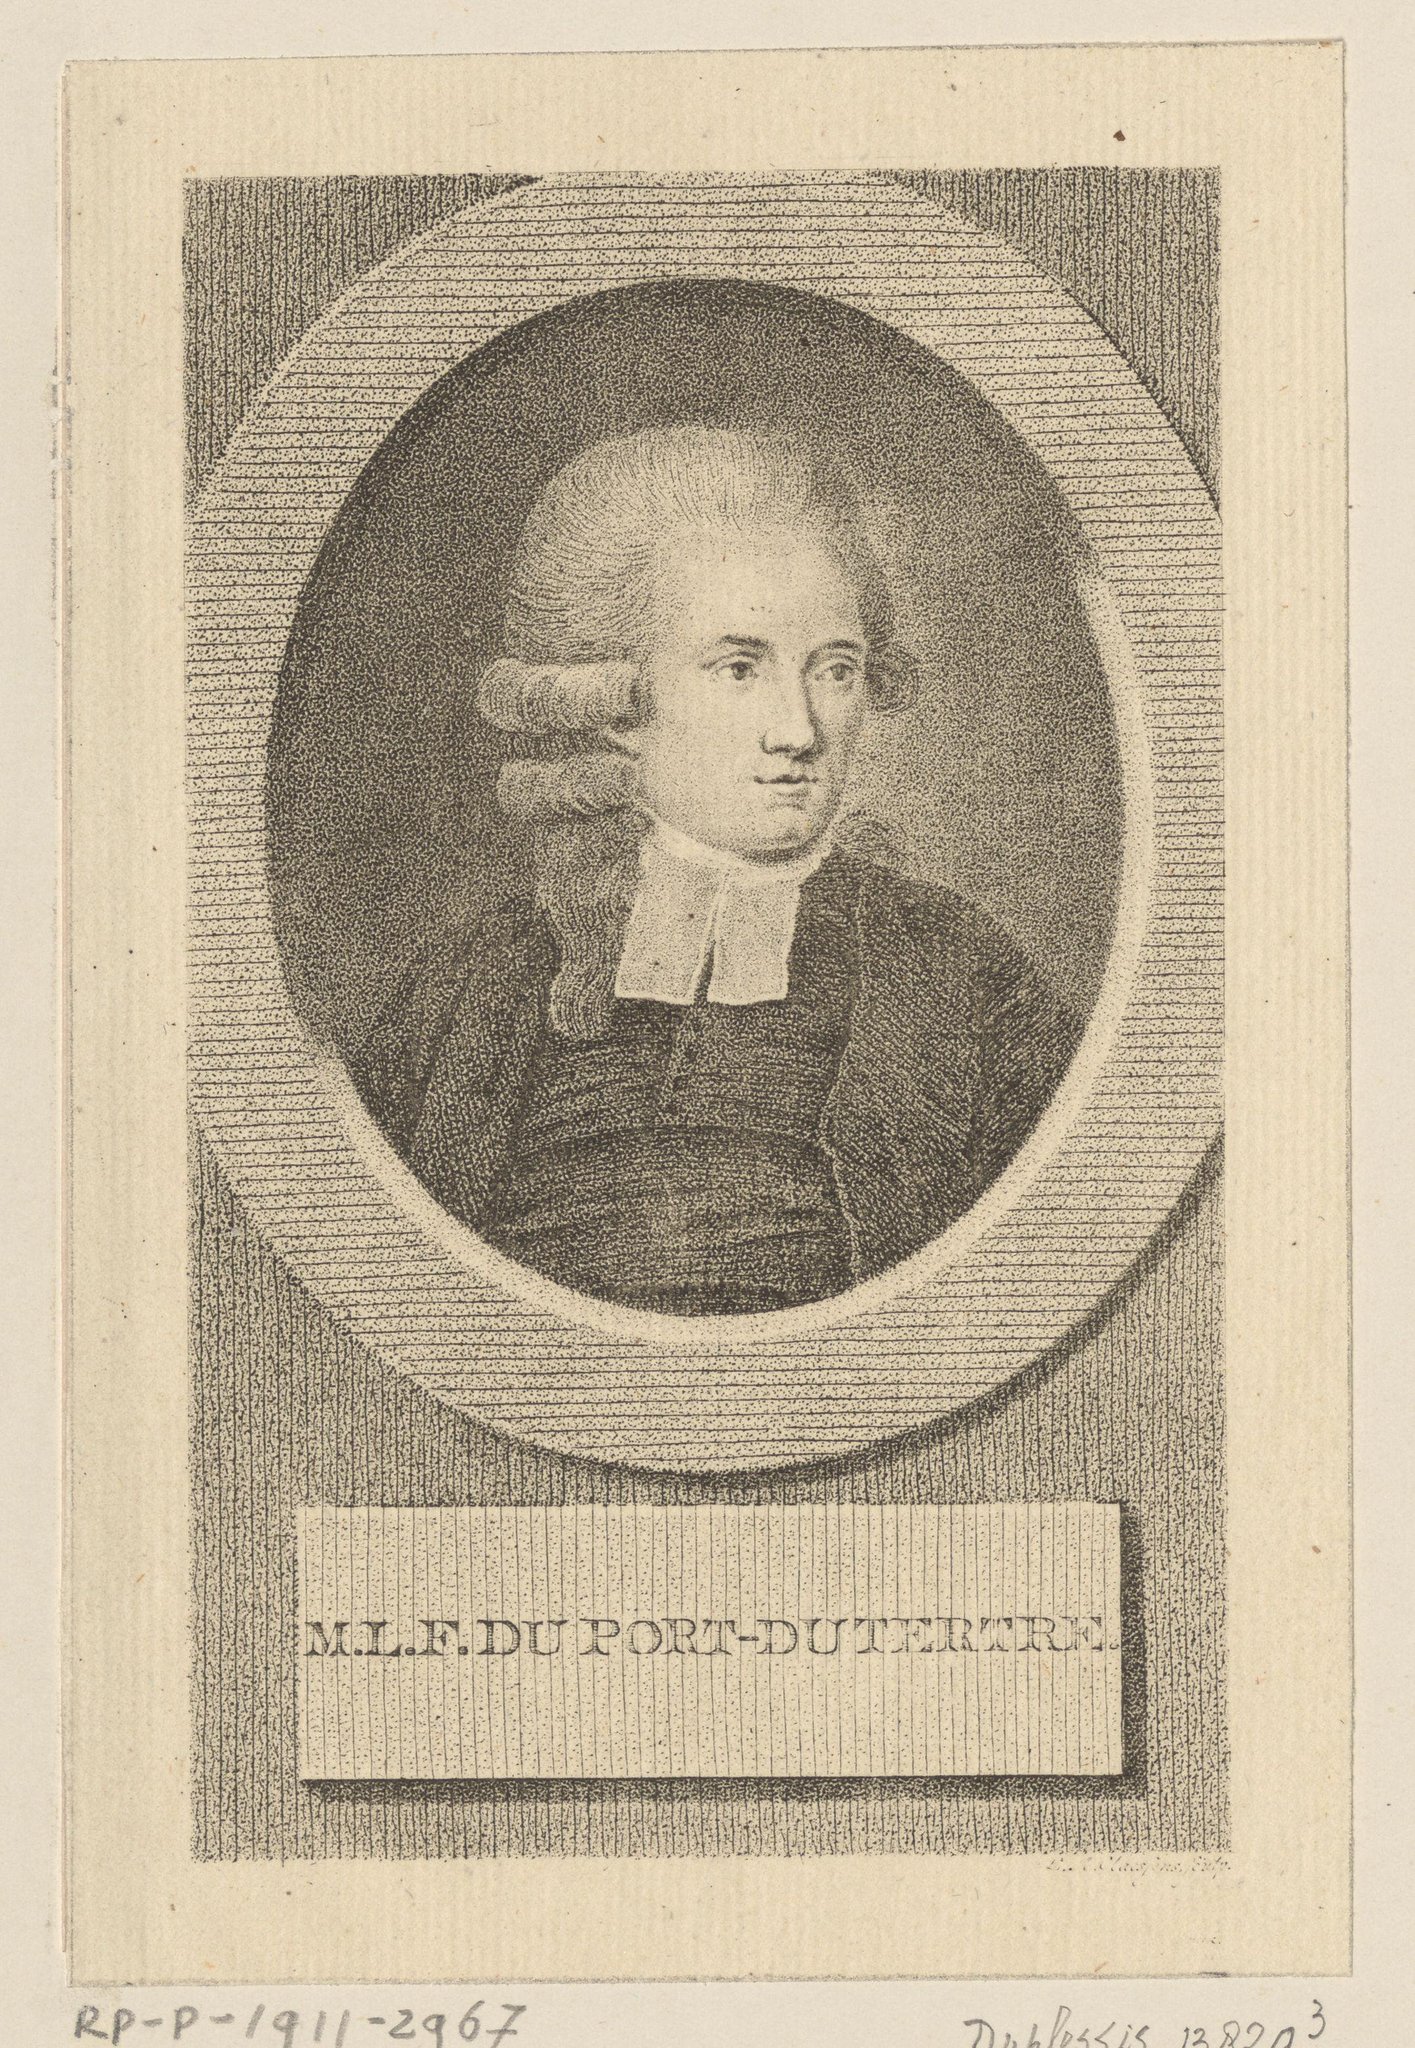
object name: print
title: Portret van Marguerite-Louis-François Duport-Dutertre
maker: lambertus antonius claessens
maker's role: draughtsman, print maker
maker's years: 1763-1834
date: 1773-1834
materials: paper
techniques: engraving, etching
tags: paris, historical persons, lawyer, attorney at law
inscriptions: collector's mark: Lugt 2228